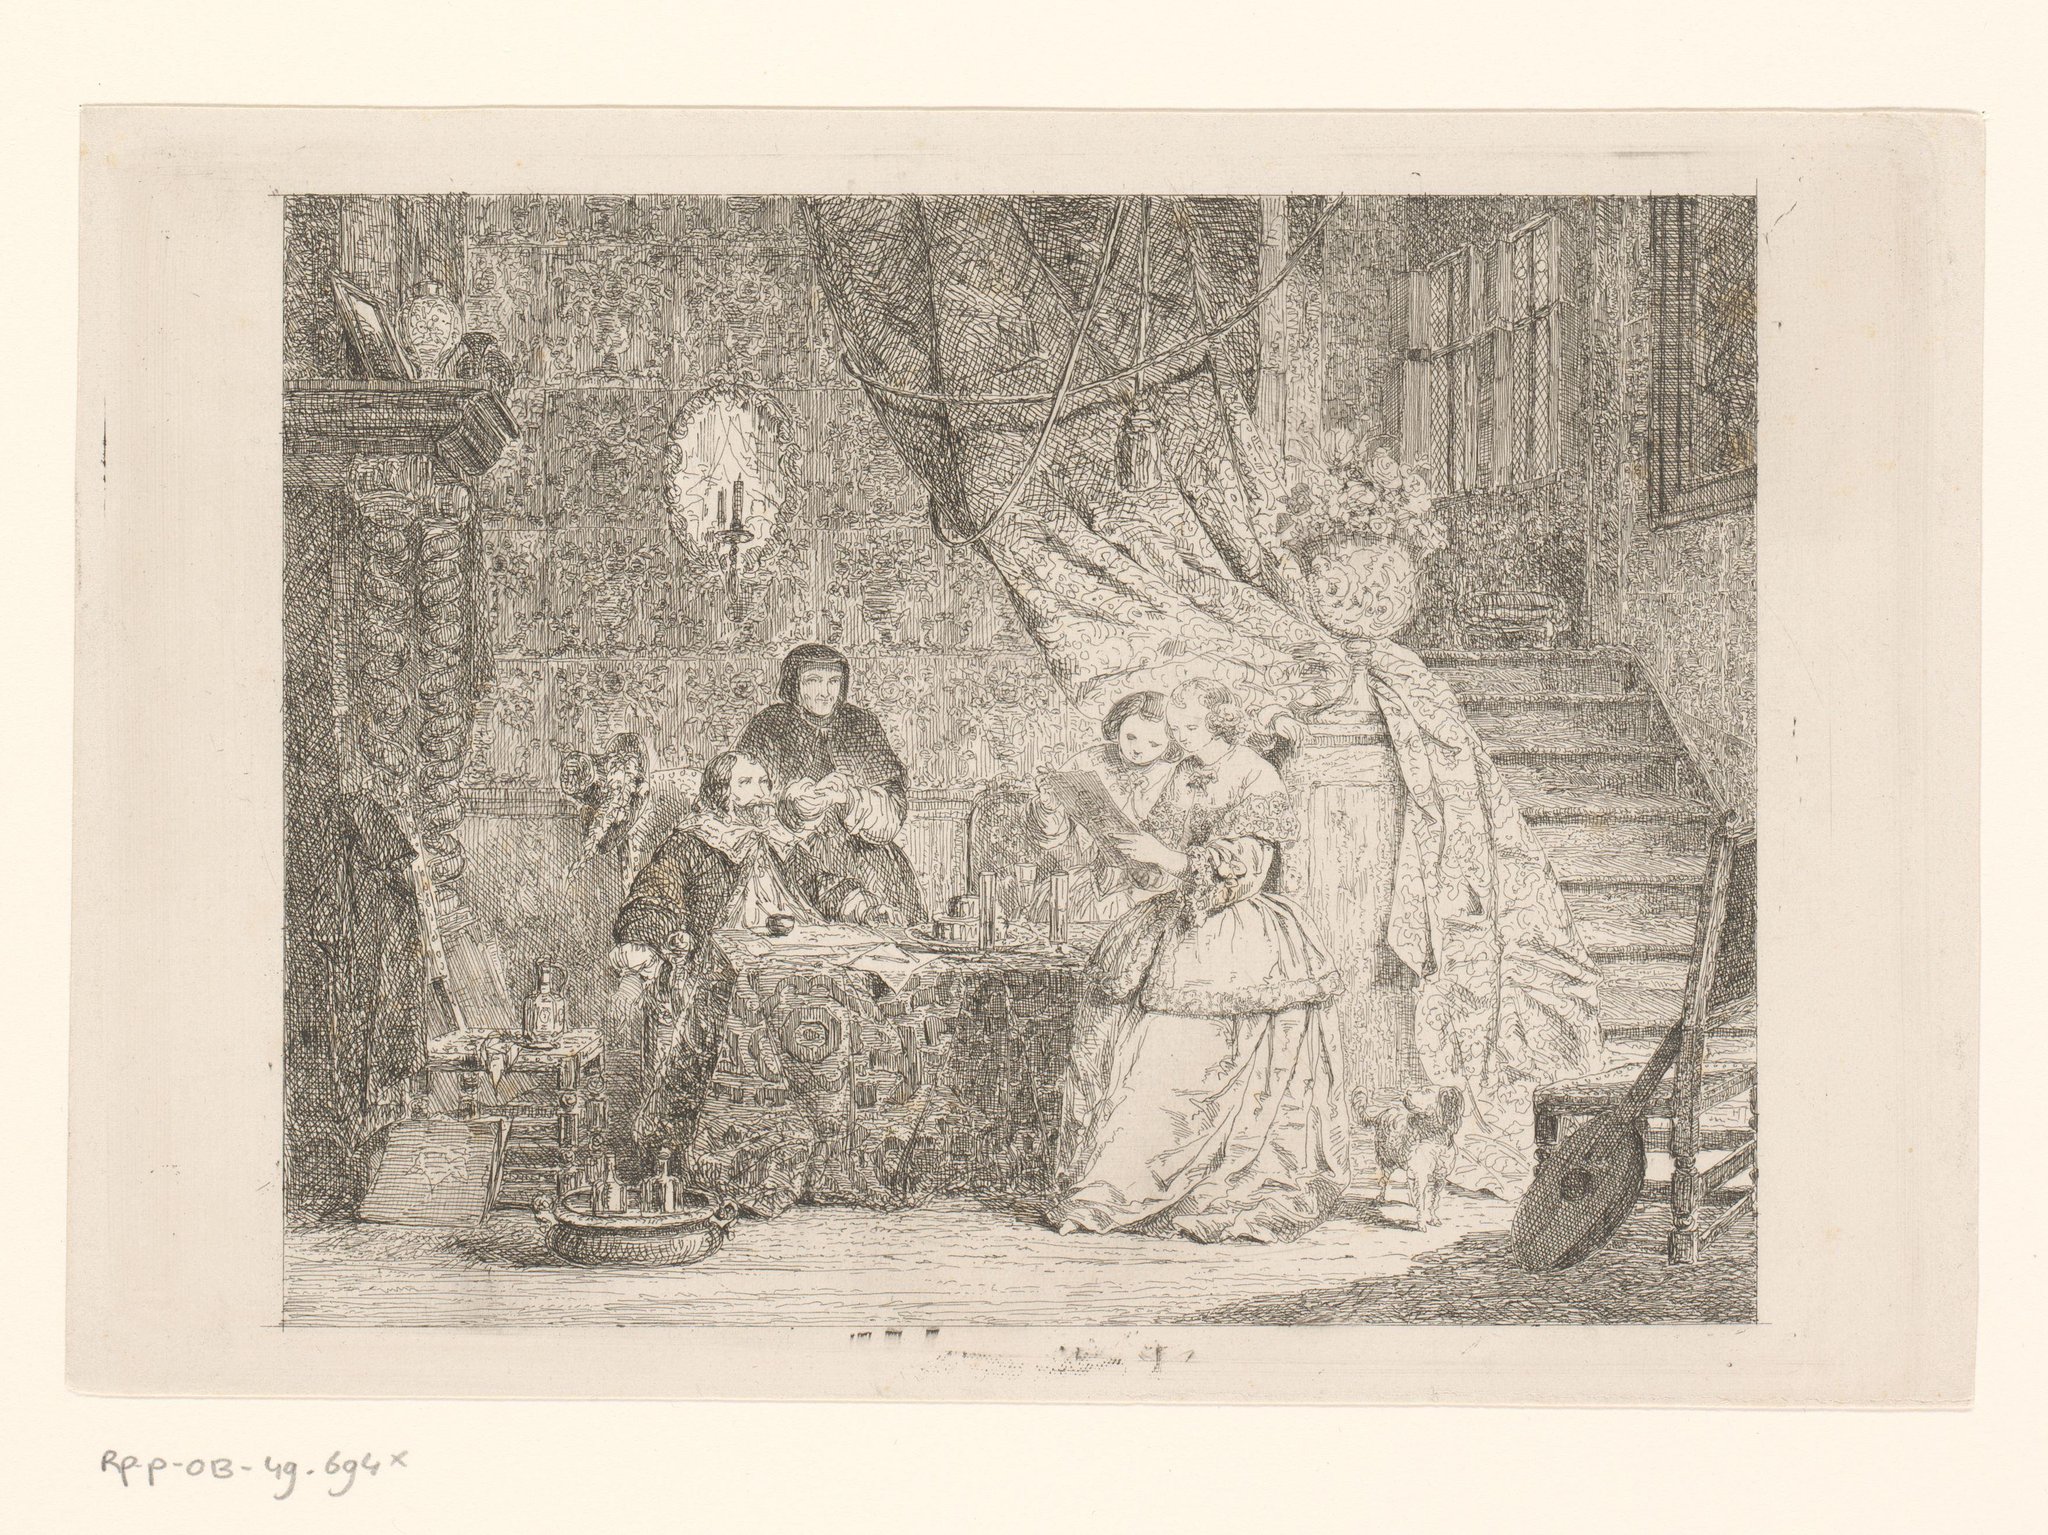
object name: print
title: Interieur met twee jonge vrouwen die een ontwerp bekijken van de kunstenaar die aan tafel zit naast een staande vrouw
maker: guillaume joseph vertommen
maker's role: print maker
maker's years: 1815-1863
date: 1825-1863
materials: paper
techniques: etching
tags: artist (in general) working from live model, interior of the house, artist (in general) making preliminary designs, sketching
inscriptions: collector's mark: Lugt 2228